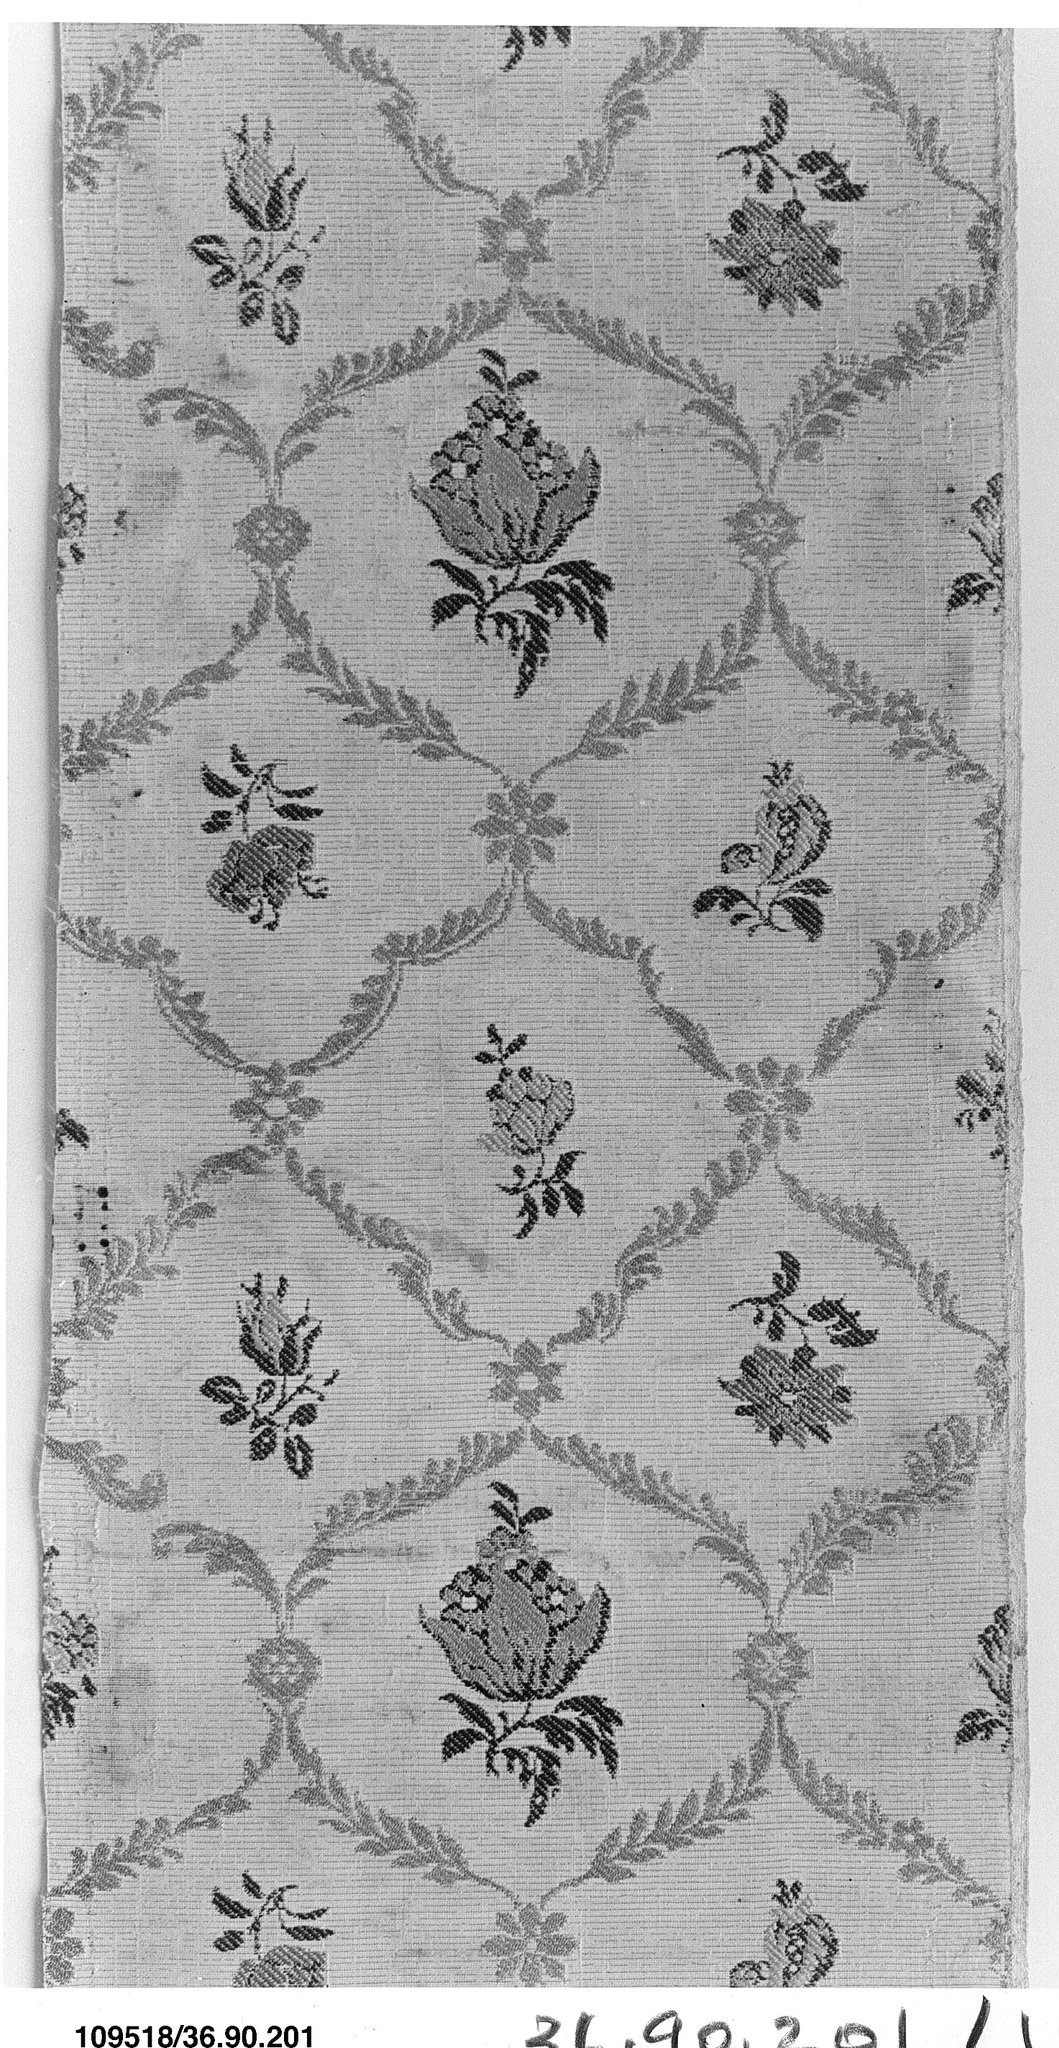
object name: piece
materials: metal thread, silk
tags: flowers